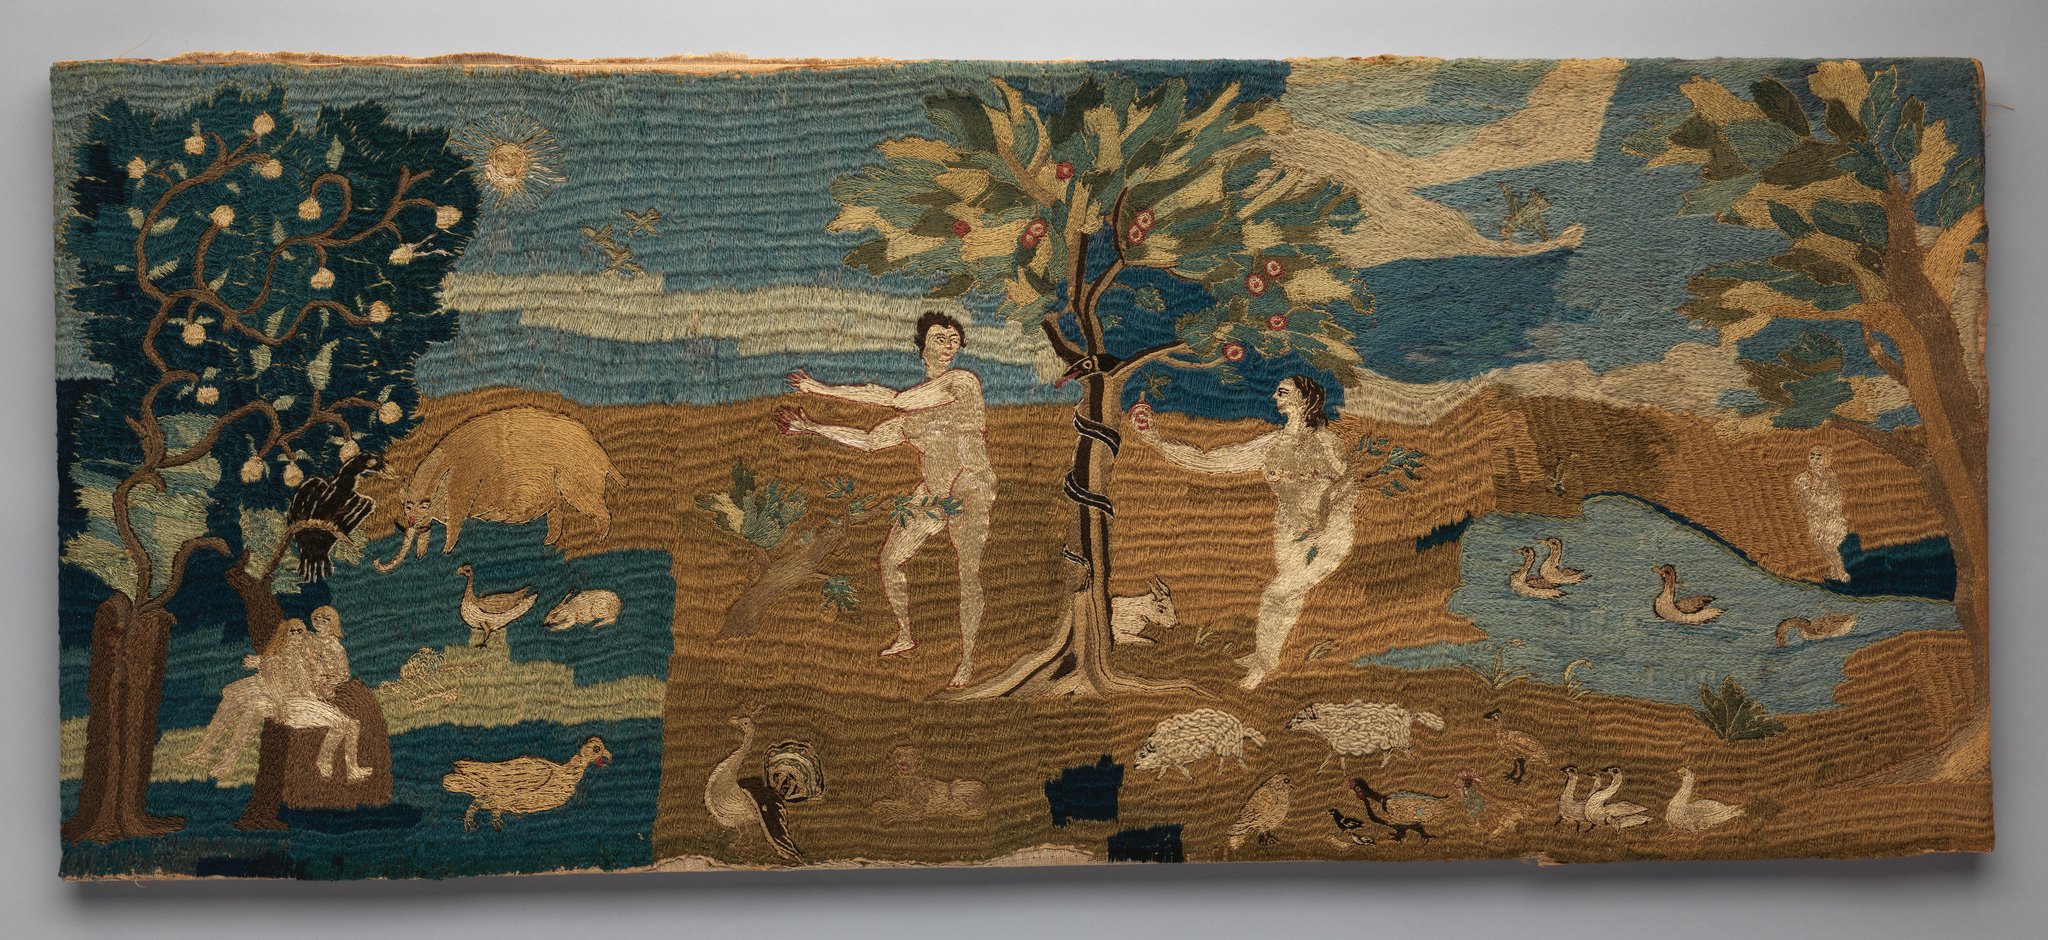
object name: chimney piece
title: Chimney piece with images of Adam and Eve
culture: american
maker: Anonymous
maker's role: artist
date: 1760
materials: linen, silk, wool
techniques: embroidery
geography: united states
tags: birds,snakes,trees,adam,eve